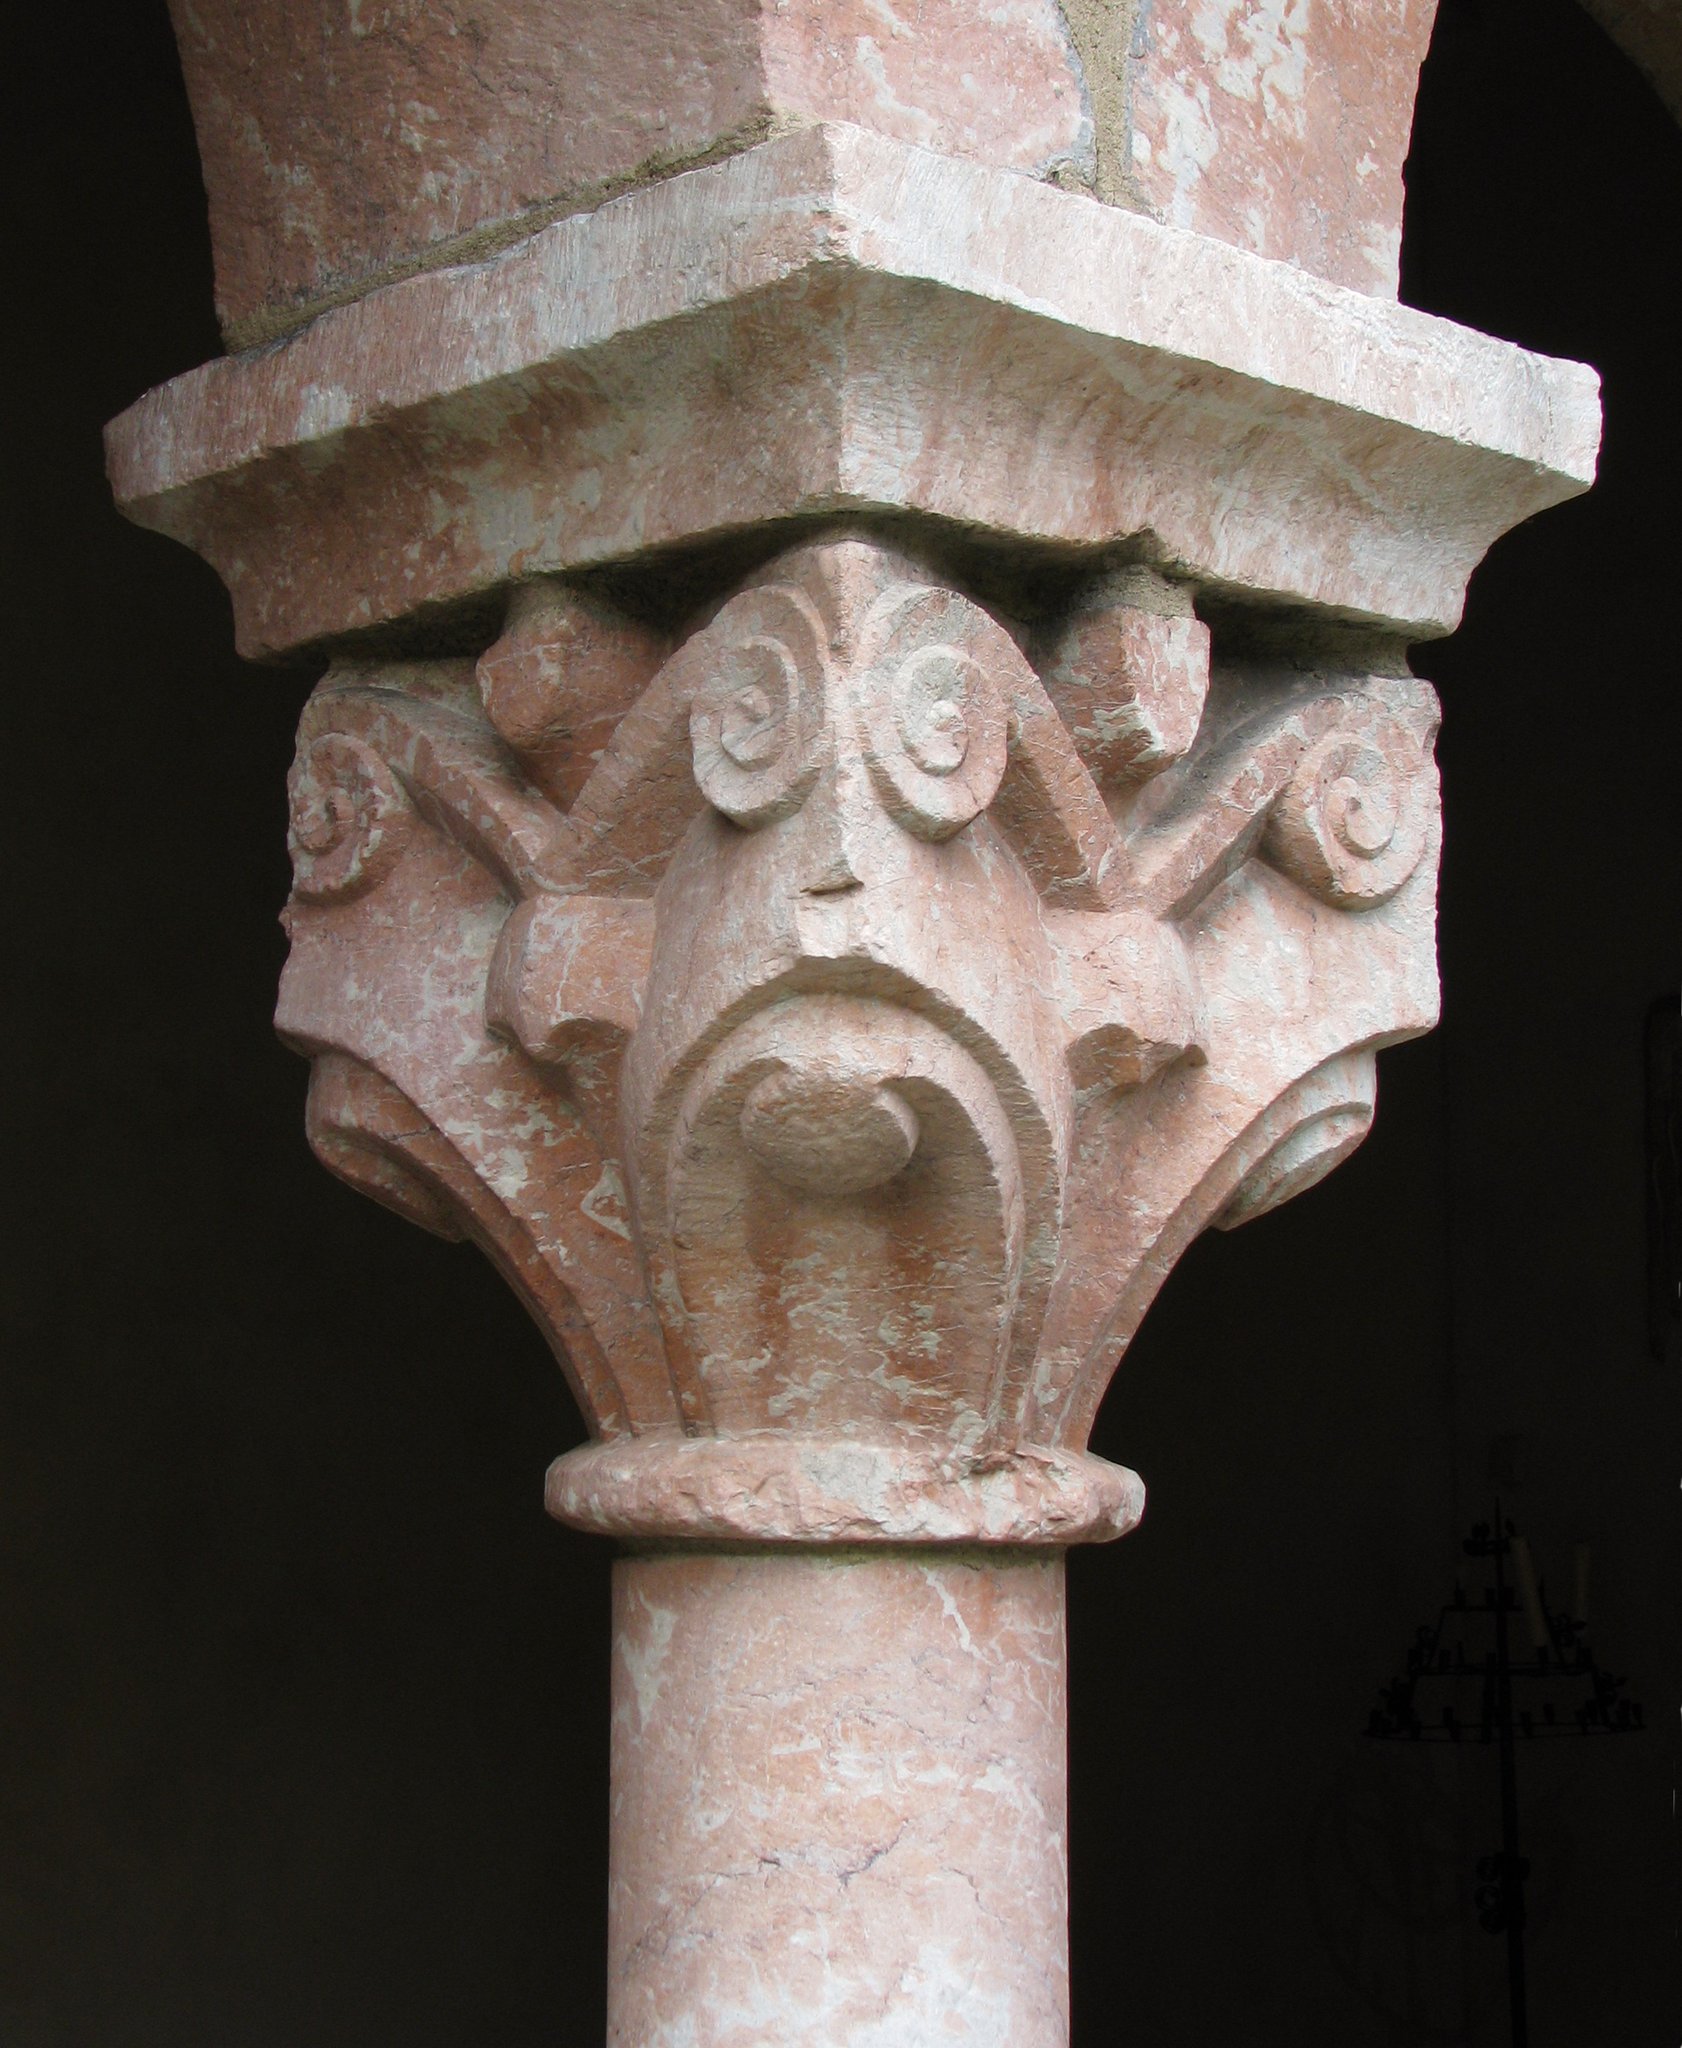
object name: capital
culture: catalan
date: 1130-1140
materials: marble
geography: france